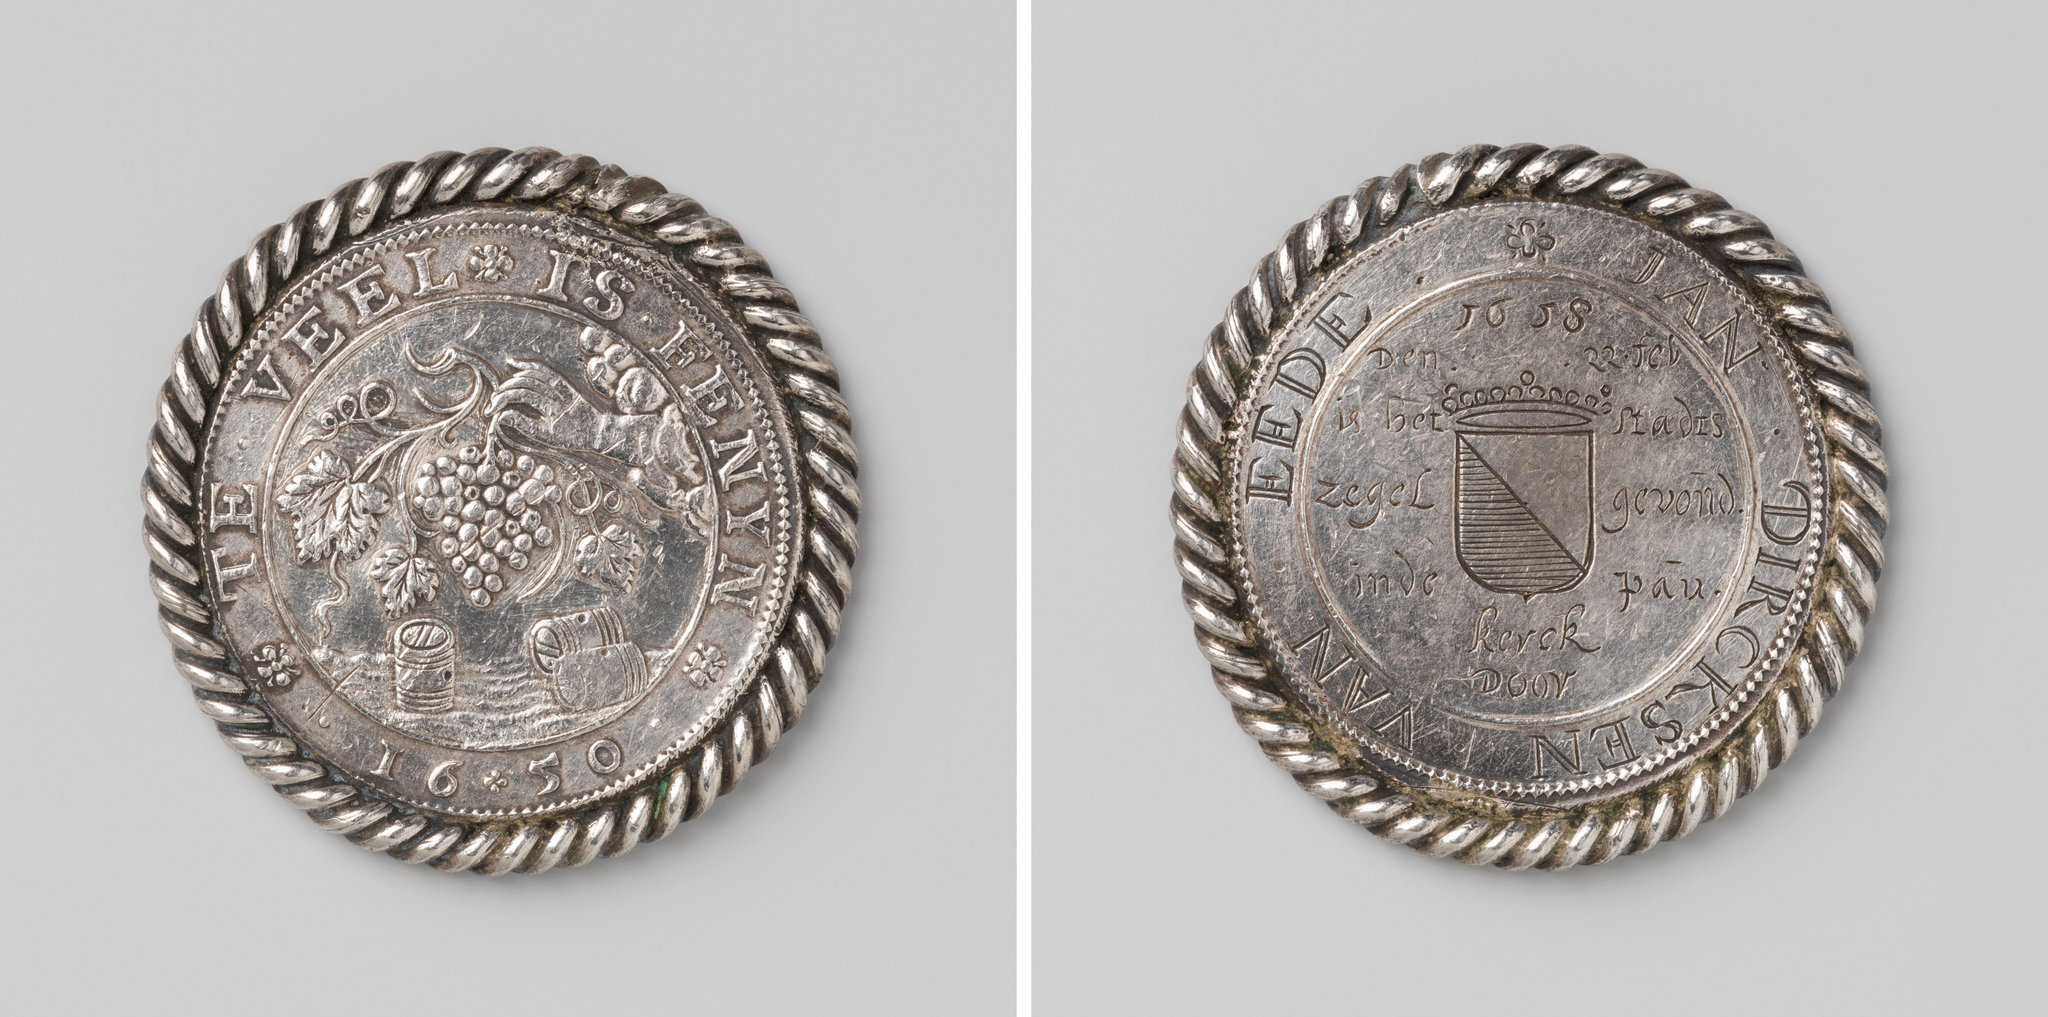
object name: medal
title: Wijnkopersgilde van Utrecht, gildepenning van Jan Dircksen van Eede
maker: Anonymous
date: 1658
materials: silver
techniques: engraving, striking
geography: utrecht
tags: utrecht